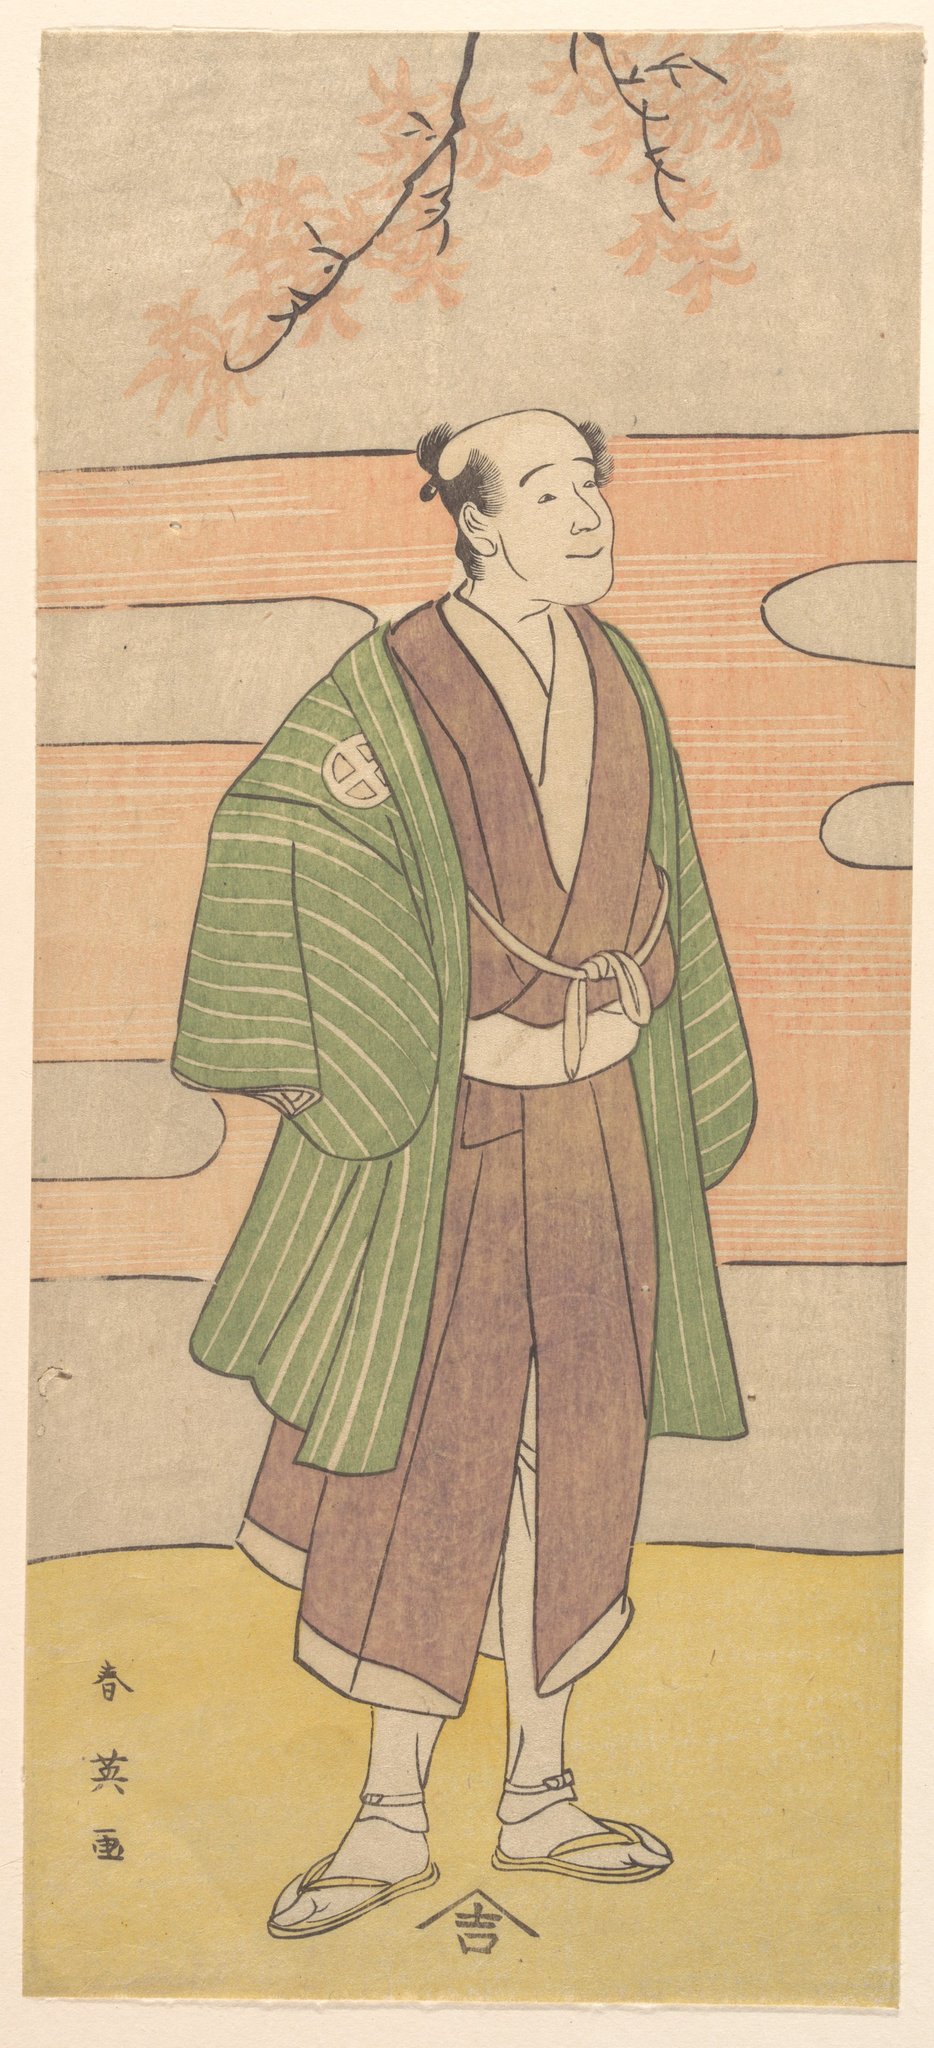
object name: print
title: The Actor Otani Oniji III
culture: japanese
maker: katsukawa shun'ei 勝川春英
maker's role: artist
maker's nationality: japanese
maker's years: 1762-1819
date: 1762-1819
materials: ink, paper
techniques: woodblock print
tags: men,actors